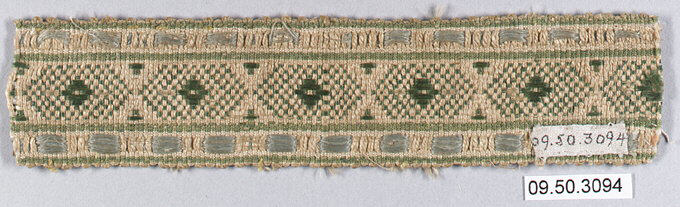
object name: gimp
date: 1701-1900